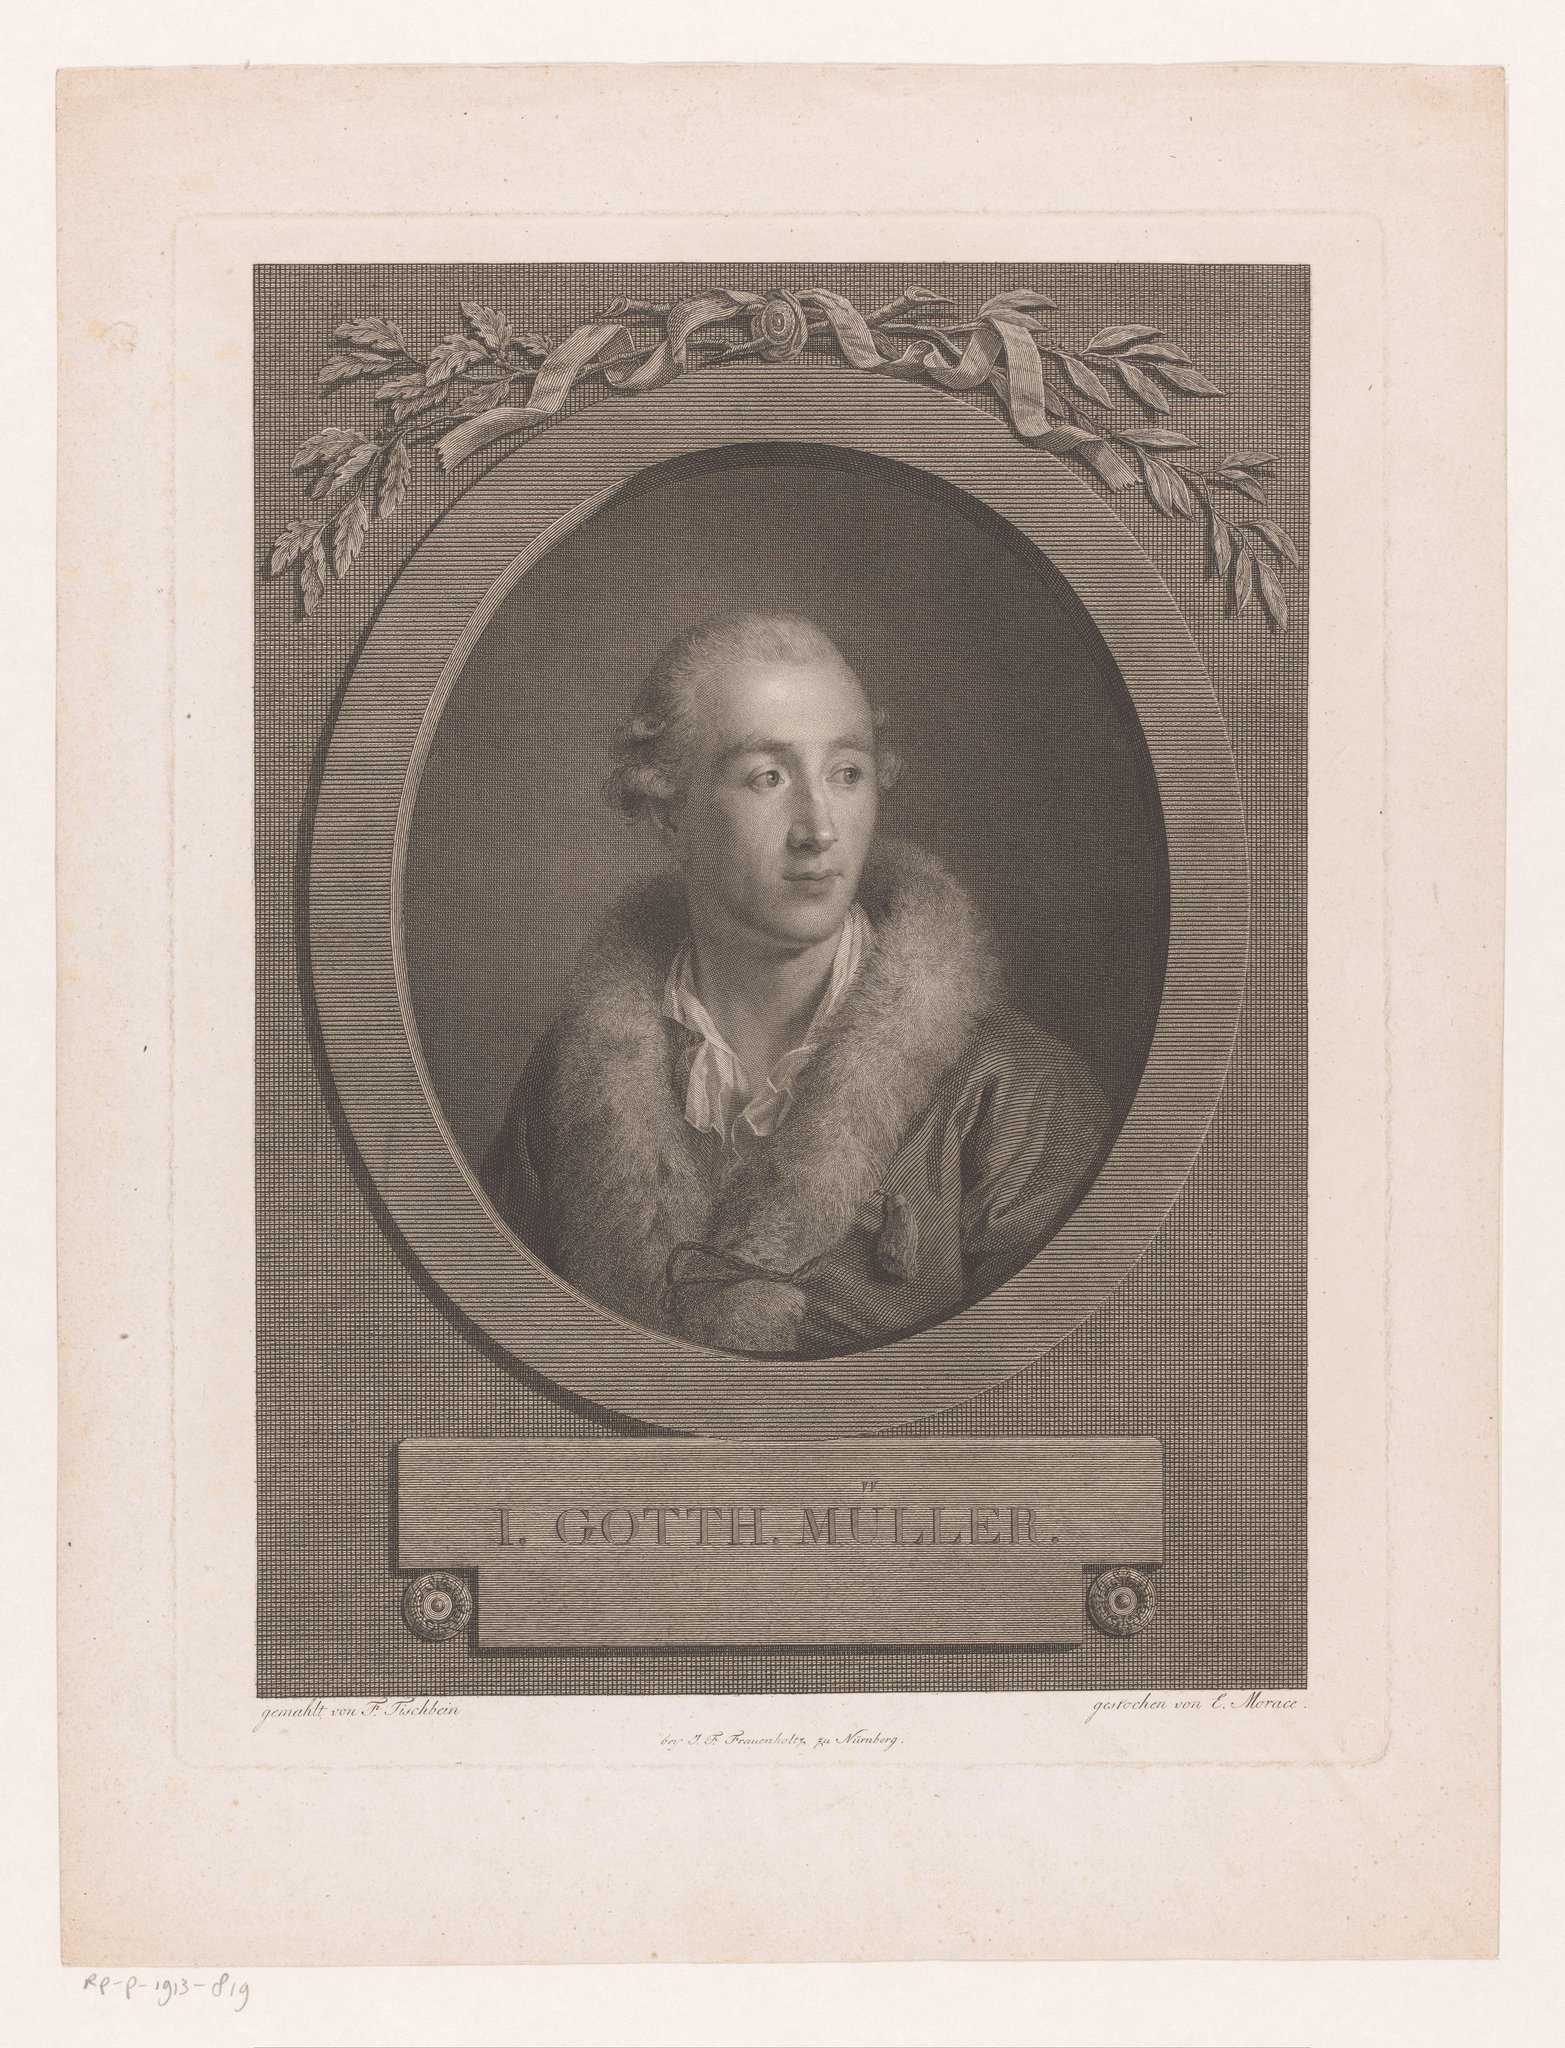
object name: print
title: Portret van Johann Gotthard Müller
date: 1776-1820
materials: paper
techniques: engraving, etching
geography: nuremberg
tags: johann gotthard müller, historical persons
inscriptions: collector's mark: Lugt 2228